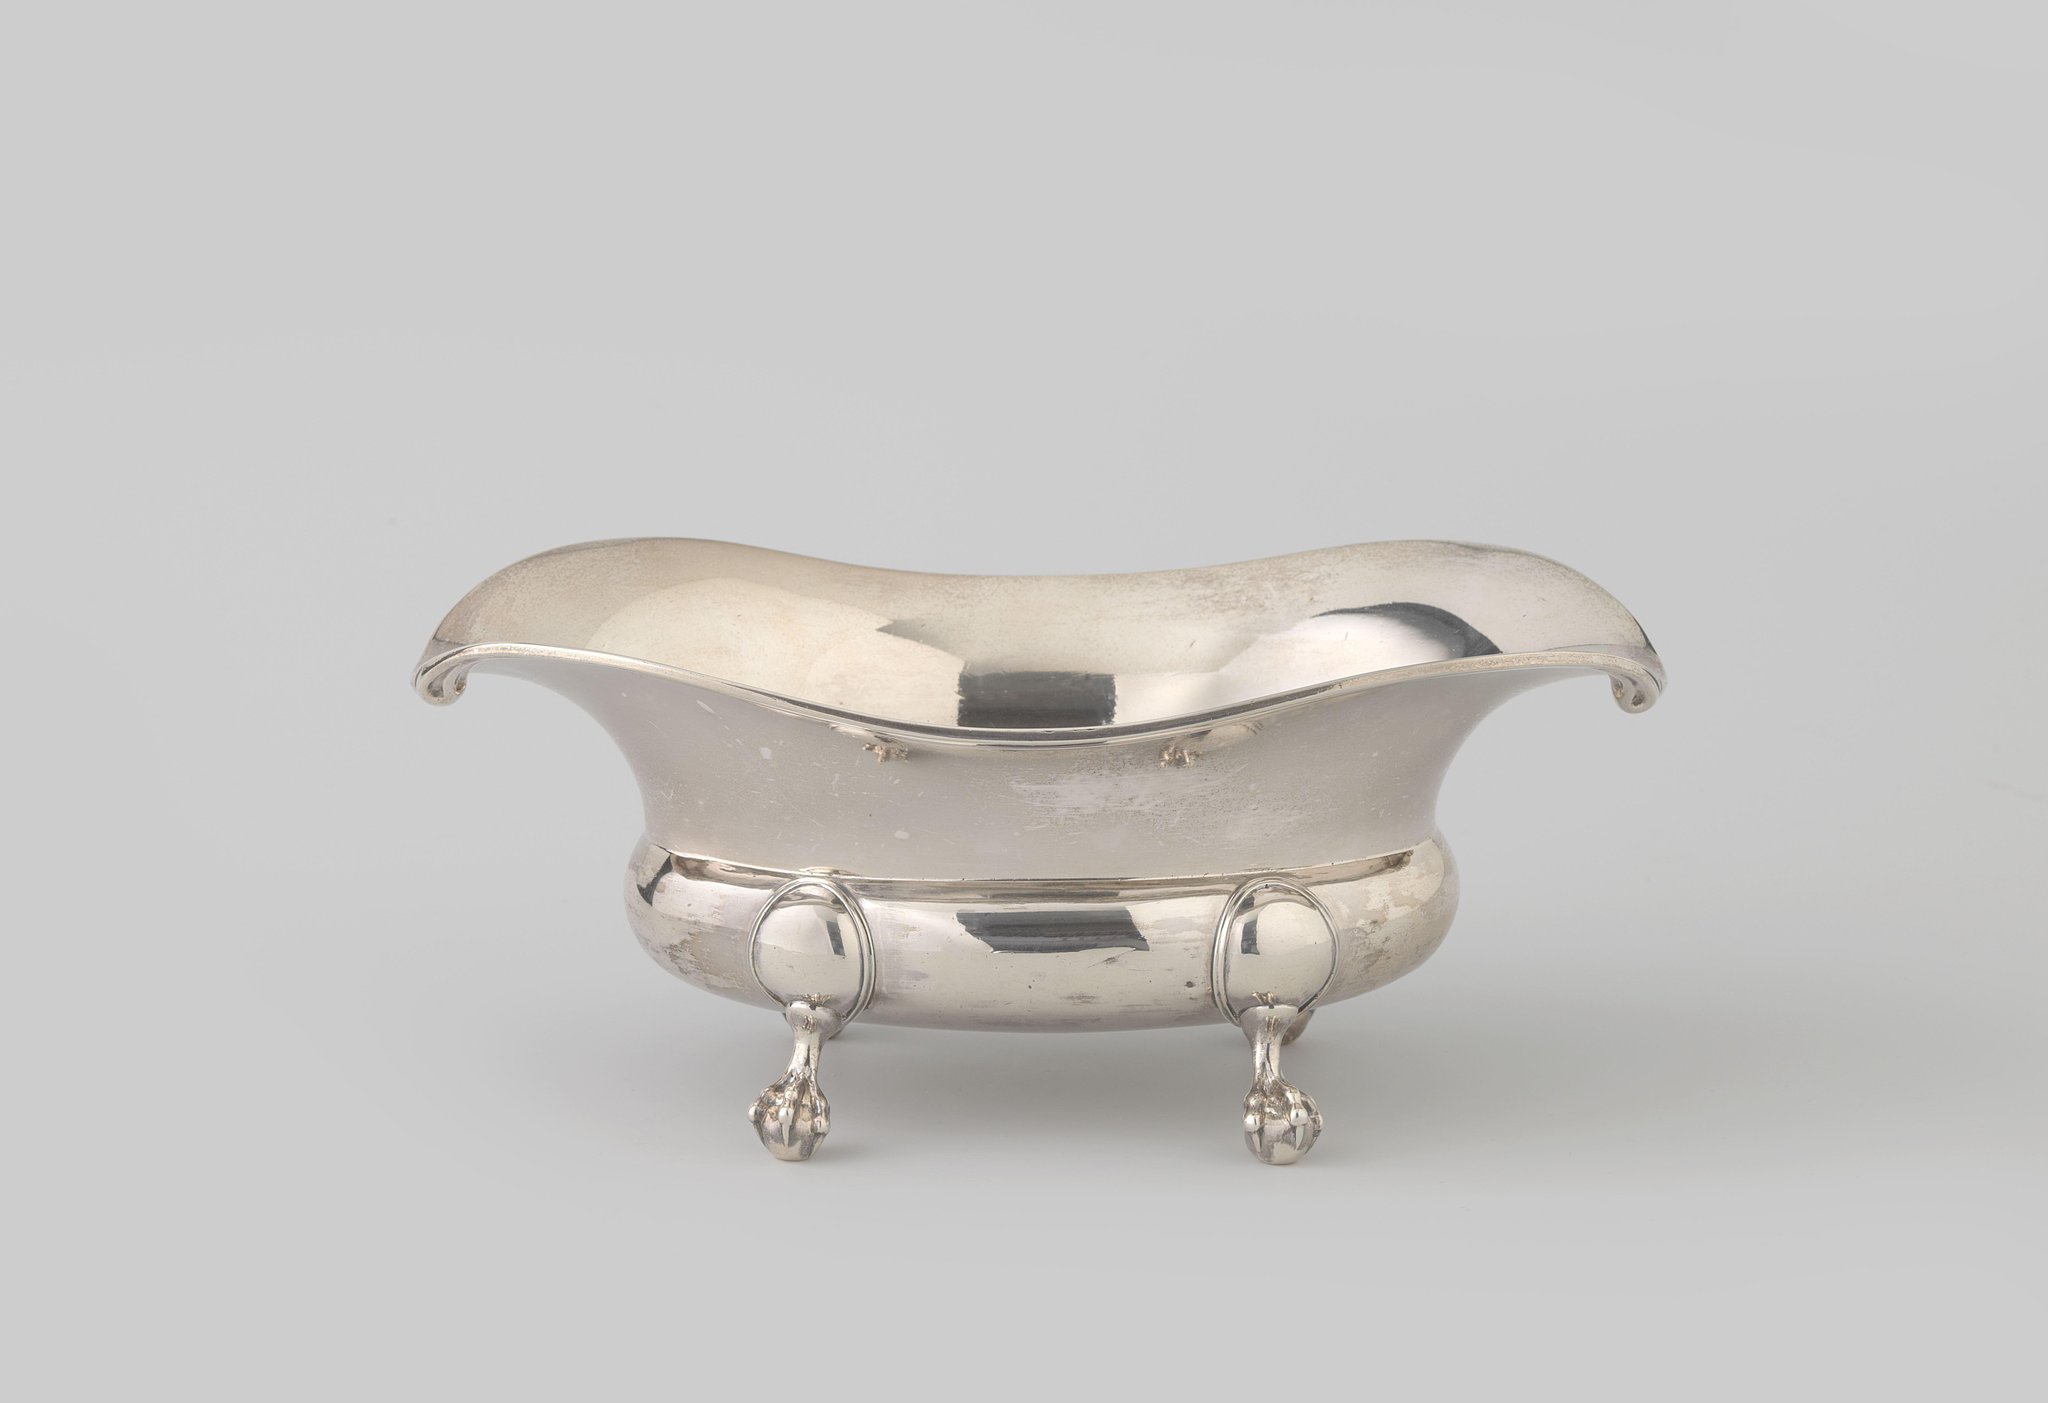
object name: sauceboat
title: Sauskom, ovaal, op vier klauwpoten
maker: anton hinrich pape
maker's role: silversmith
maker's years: 1746-1816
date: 1789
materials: silver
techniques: casting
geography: amsterdam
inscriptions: assay office mark, alloy mark, maker's mark, : ‘ZI’, date letter: ‘E’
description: Sauce boat. Silver. Amsterdam, 1789, by Anton Hendrik Paap.